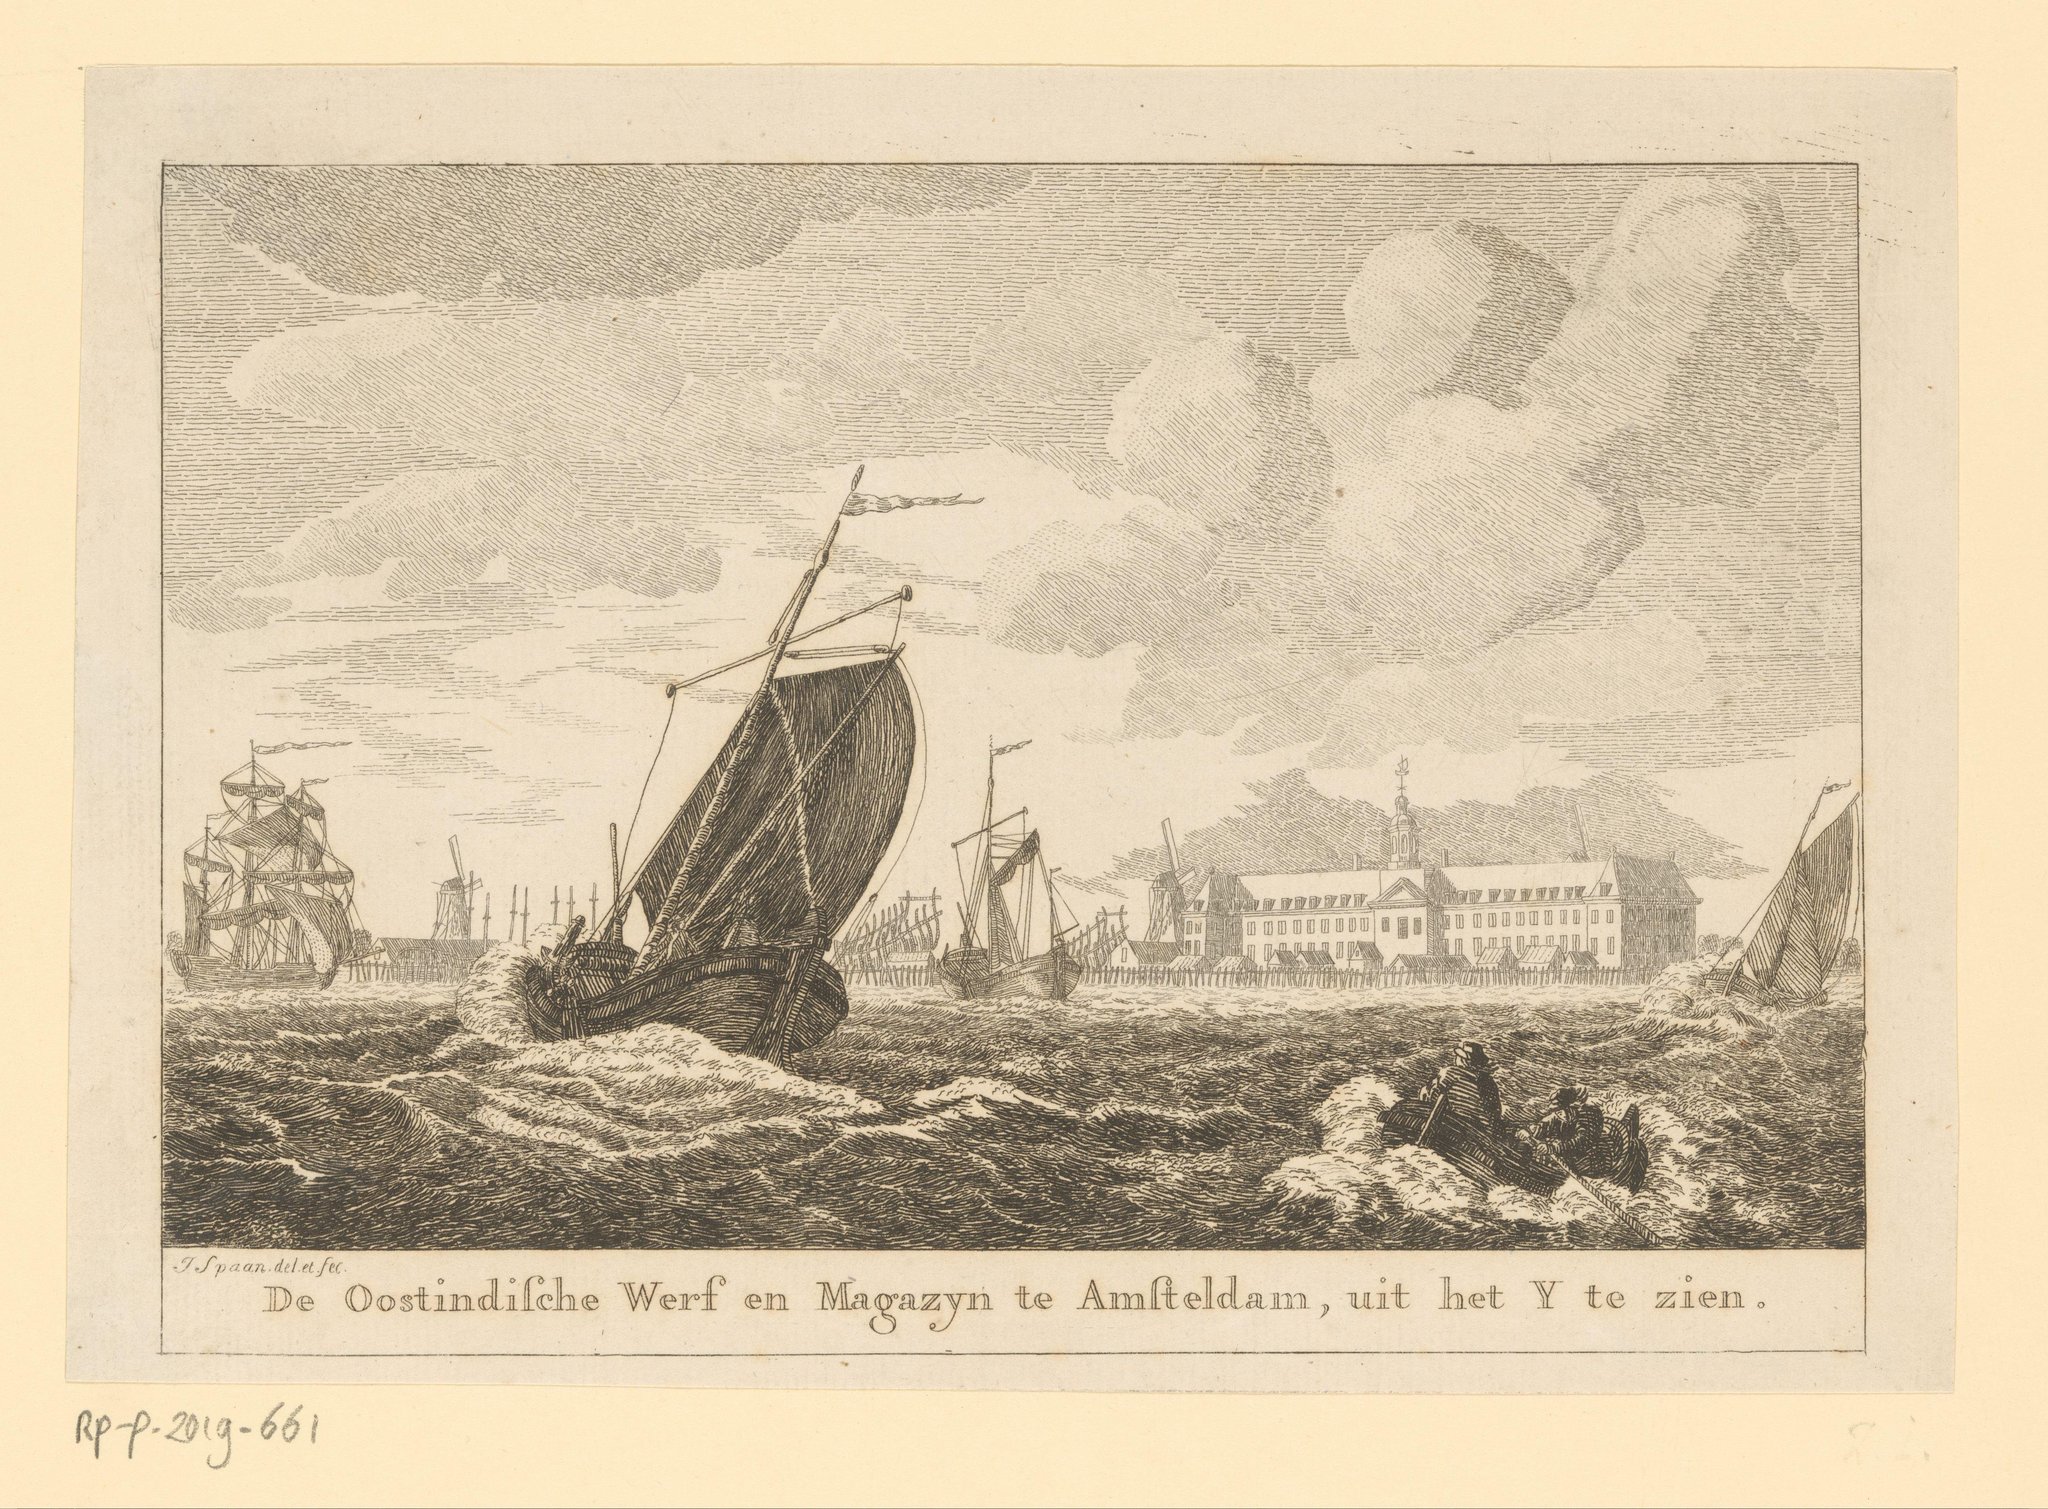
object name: print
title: De Oostindische Werf en Magazyn te Amsteldam, uit het Y te zien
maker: jan spaan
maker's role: print maker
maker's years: 1742-1828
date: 1757-1799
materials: paper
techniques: etching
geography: amsterdam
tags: warehouse (~ harbour), canals, waters (in city), ships (in general) - cc - more than one ship, shipyard, shipdock